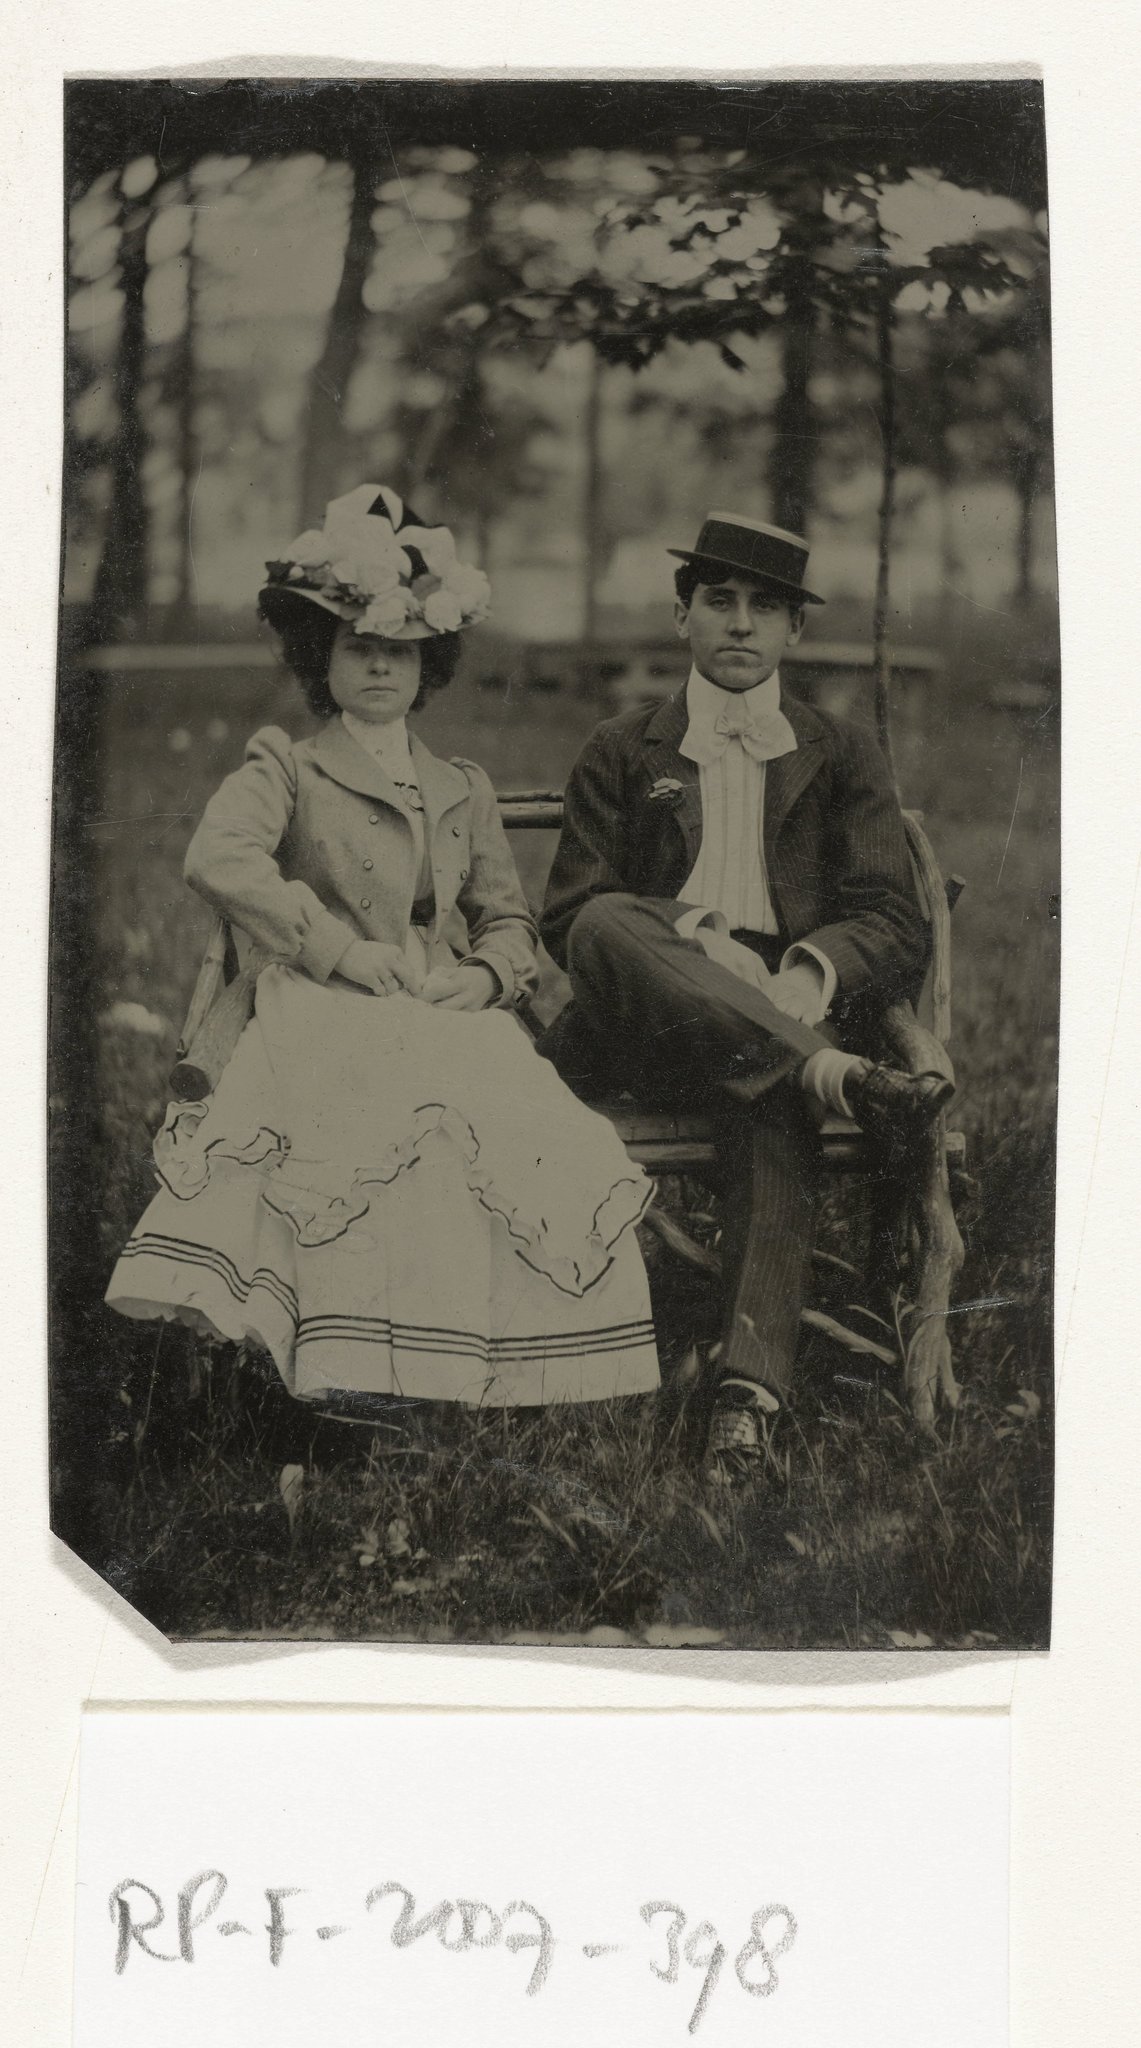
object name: photograph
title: Portrait of a man and a woman sitting on a bench in a forest or park-like setting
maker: Anonymous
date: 1880-1910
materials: metal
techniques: ferrotyping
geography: united states